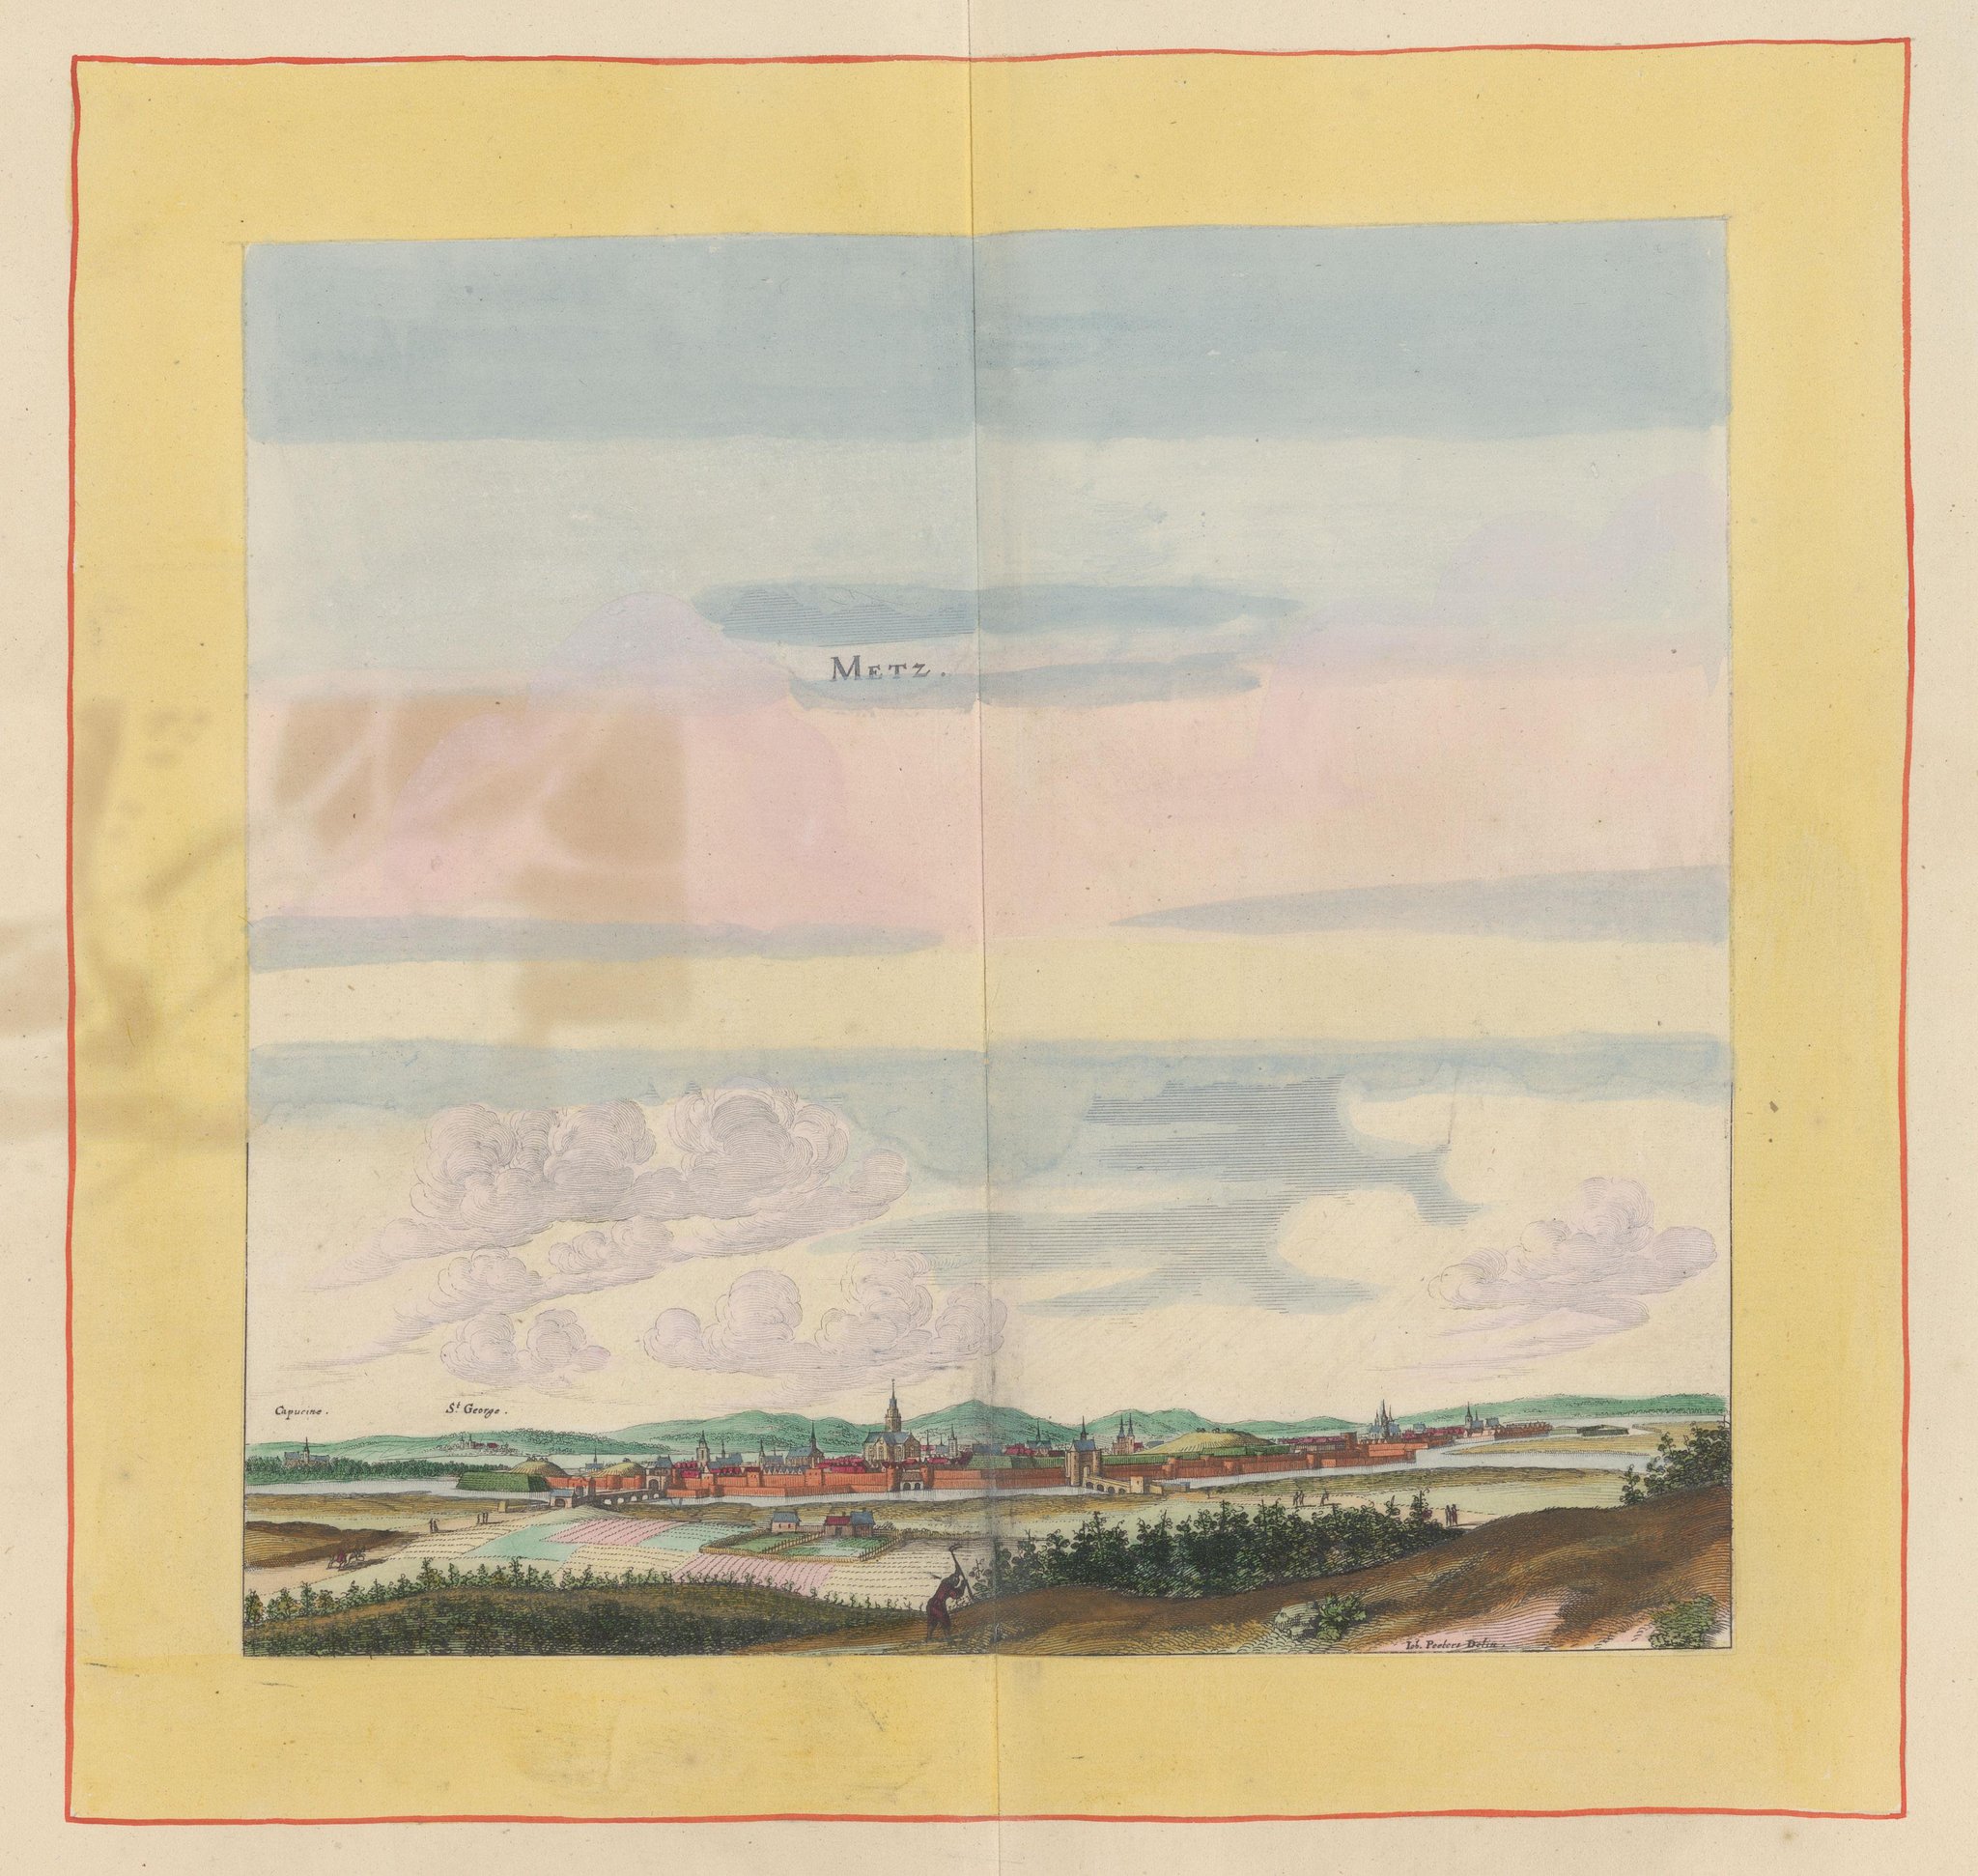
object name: print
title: Gezicht op Metz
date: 1656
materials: paper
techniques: engraving, etching, hand coloring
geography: frankfurt am main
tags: maps of cities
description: Prent uit: Zeiller, Martin. Topographia Galliae. 13 dln. Frankfurt: Caspar Merian, 1656, dl. 3, na p. 18. Origineel op één blad gedrukt met het gezicht op Méry-sur-Seine (RP-P-1957-607-113-2).